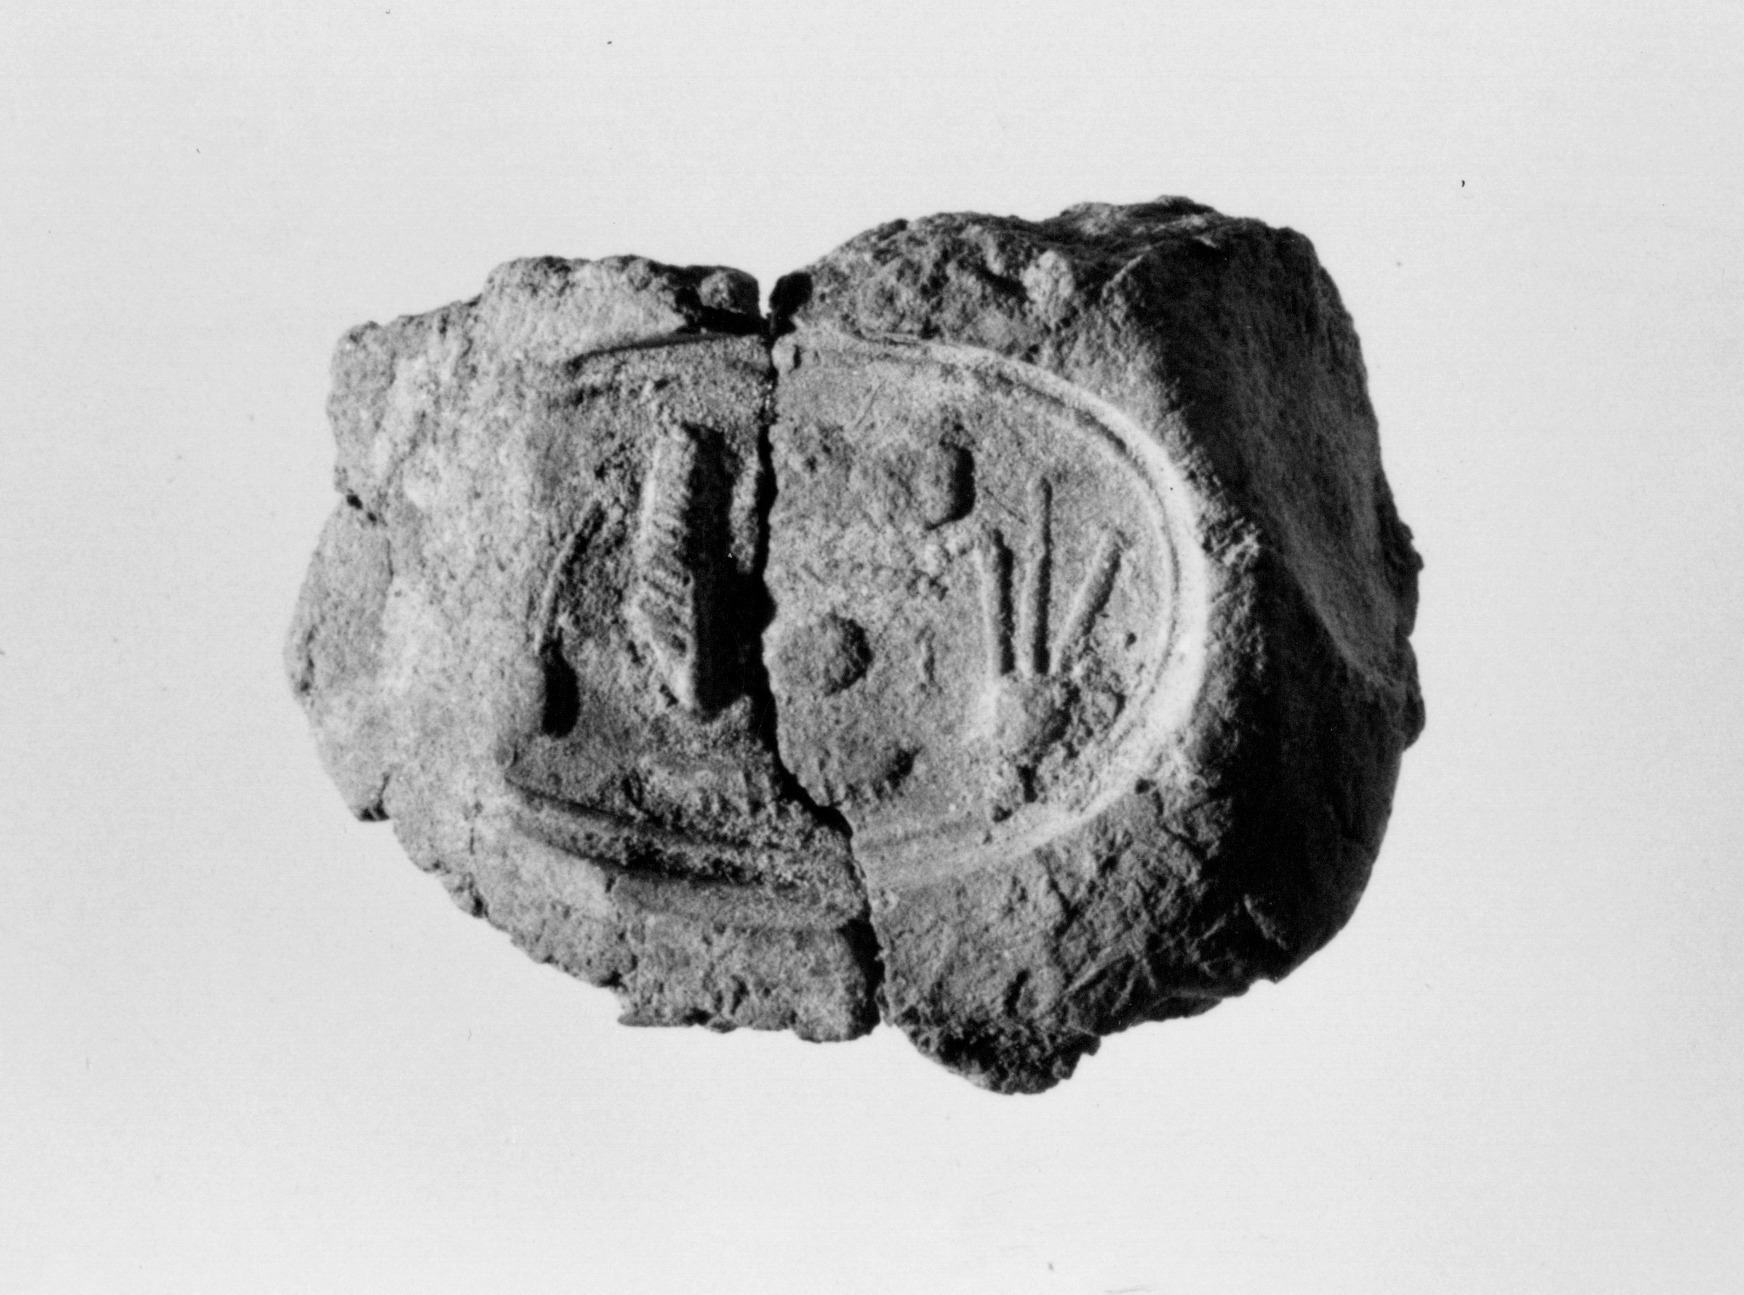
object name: sealing, amun re, upper egypt, lower egypt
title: Document Sealing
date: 1390-1352 BCE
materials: mud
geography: egypt